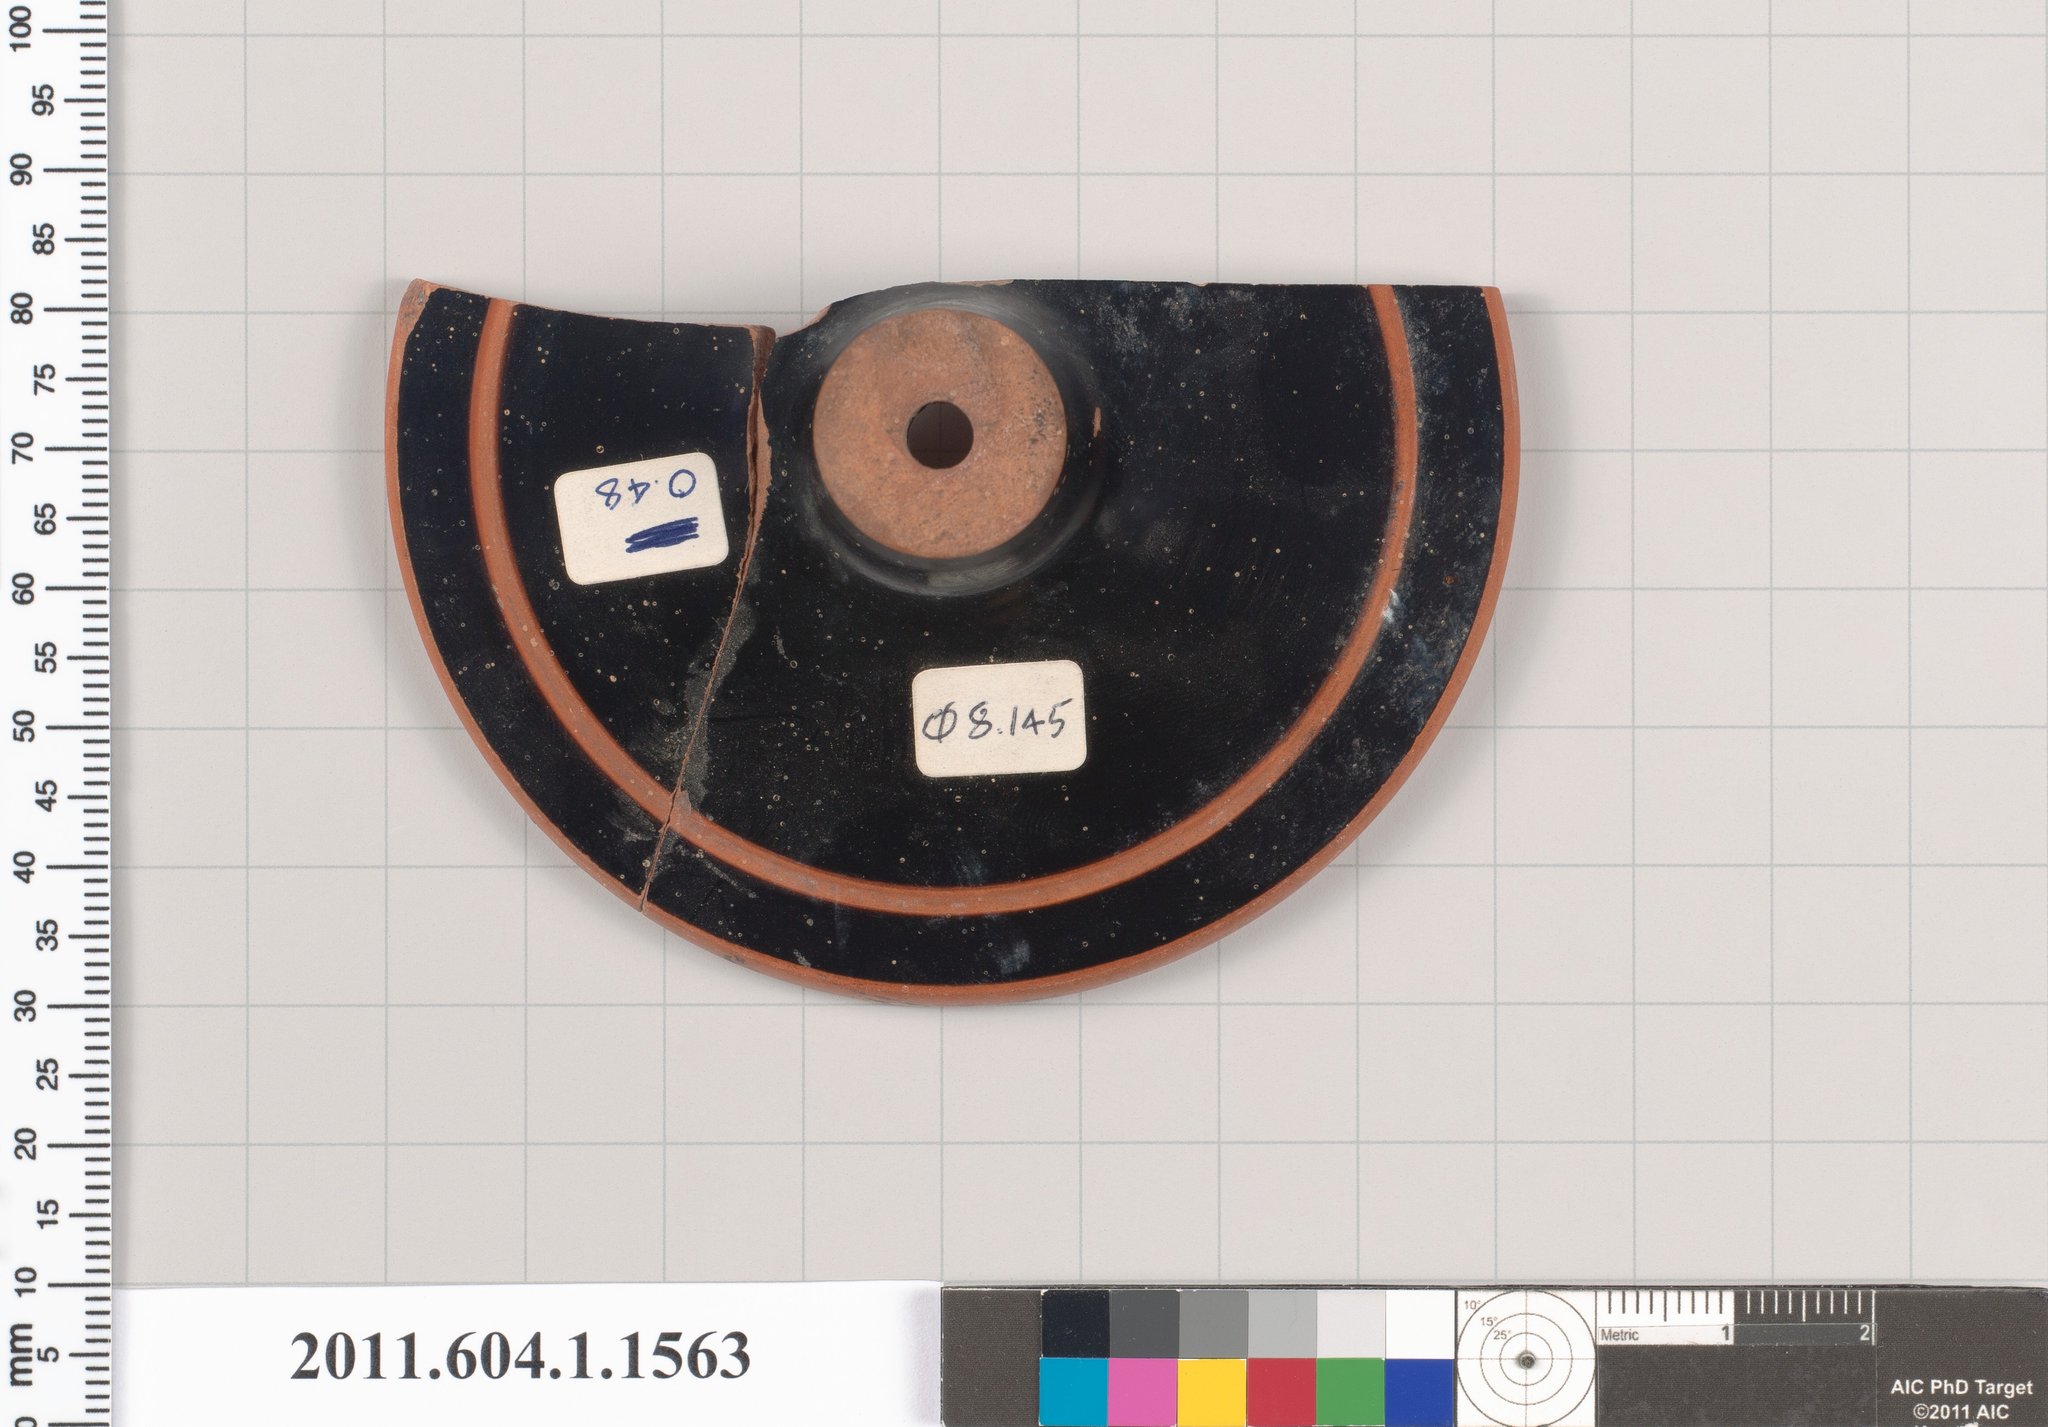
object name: kylix fragment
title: Terracotta fragment of a kylix (drinking cup)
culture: greek, attic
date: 500-401 BCE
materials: terracotta